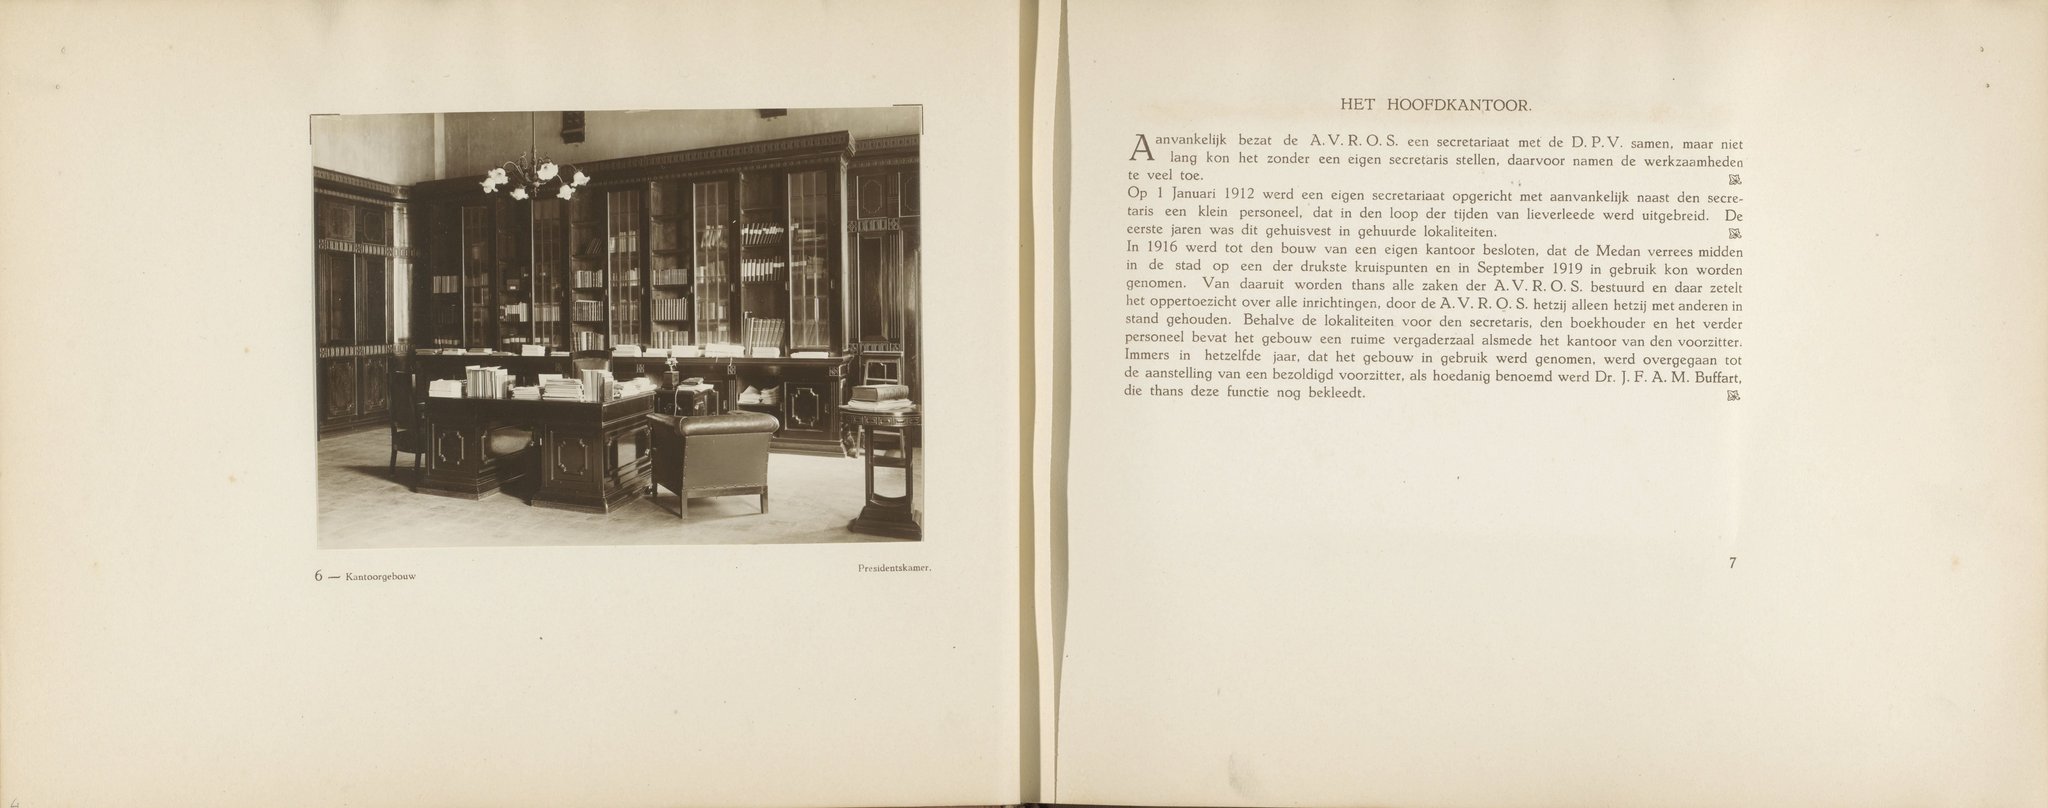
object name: photograph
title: Pagina 6 en 7 van fotoboek van de Algemeene Vereeniging van Rubberplanters ter Oostkust van Sumatra (A.V.R.O.S.)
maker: j.w. meyster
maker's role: fotograaf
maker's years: 1887-1945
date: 1924-1925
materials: paper, photographic support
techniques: printing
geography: sumatra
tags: (non-fruit) products of plants or trees: rubber, civic architecture; edifices; dwellings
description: Twee boekpagina's met links een foto van de presidentskamer van de A.V.R.O.S. te Medan en rechts informatie over het hoofdkantoor van de vereniging. Onderdeel van een fotoboek van de Algemeene Vereeniging van Rubberplanters ter Oostkust van Sumatra (A.V.R.O.S.).